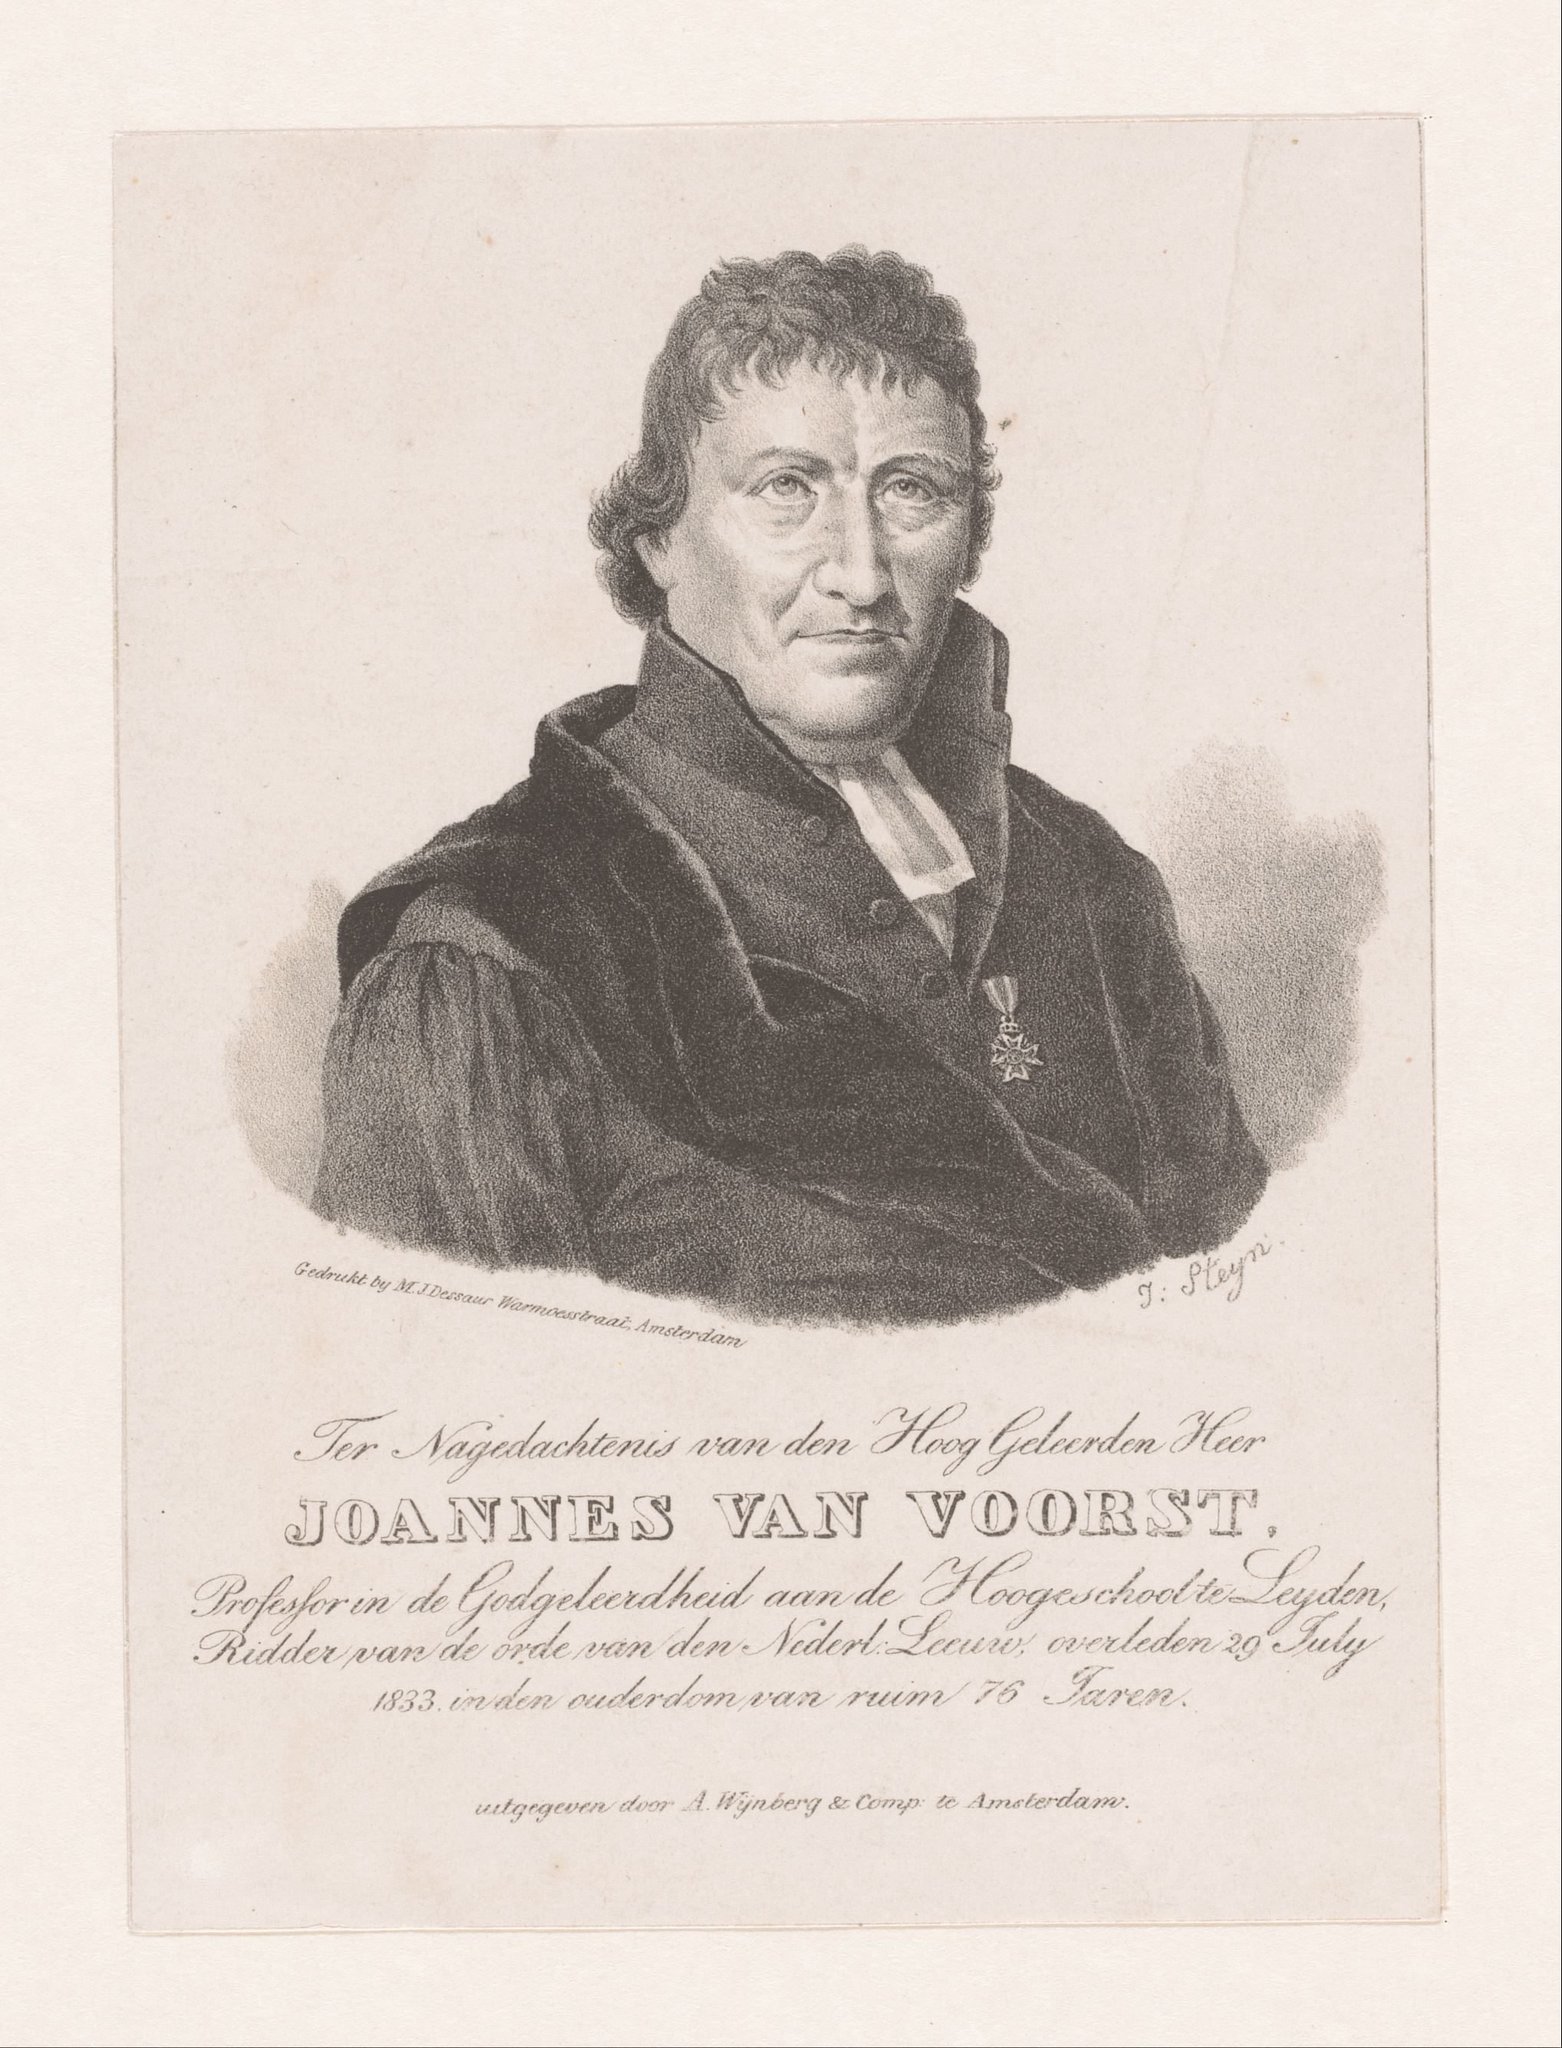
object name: print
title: Ter Nagedachtenis van den Hoog Geleerden Heer Joannes van Voorst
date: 1833-1840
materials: paper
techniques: lithograph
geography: amsterdam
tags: delft, historical persons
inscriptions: collector's mark: Lugt 2760, collector's mark: Lugt 2228